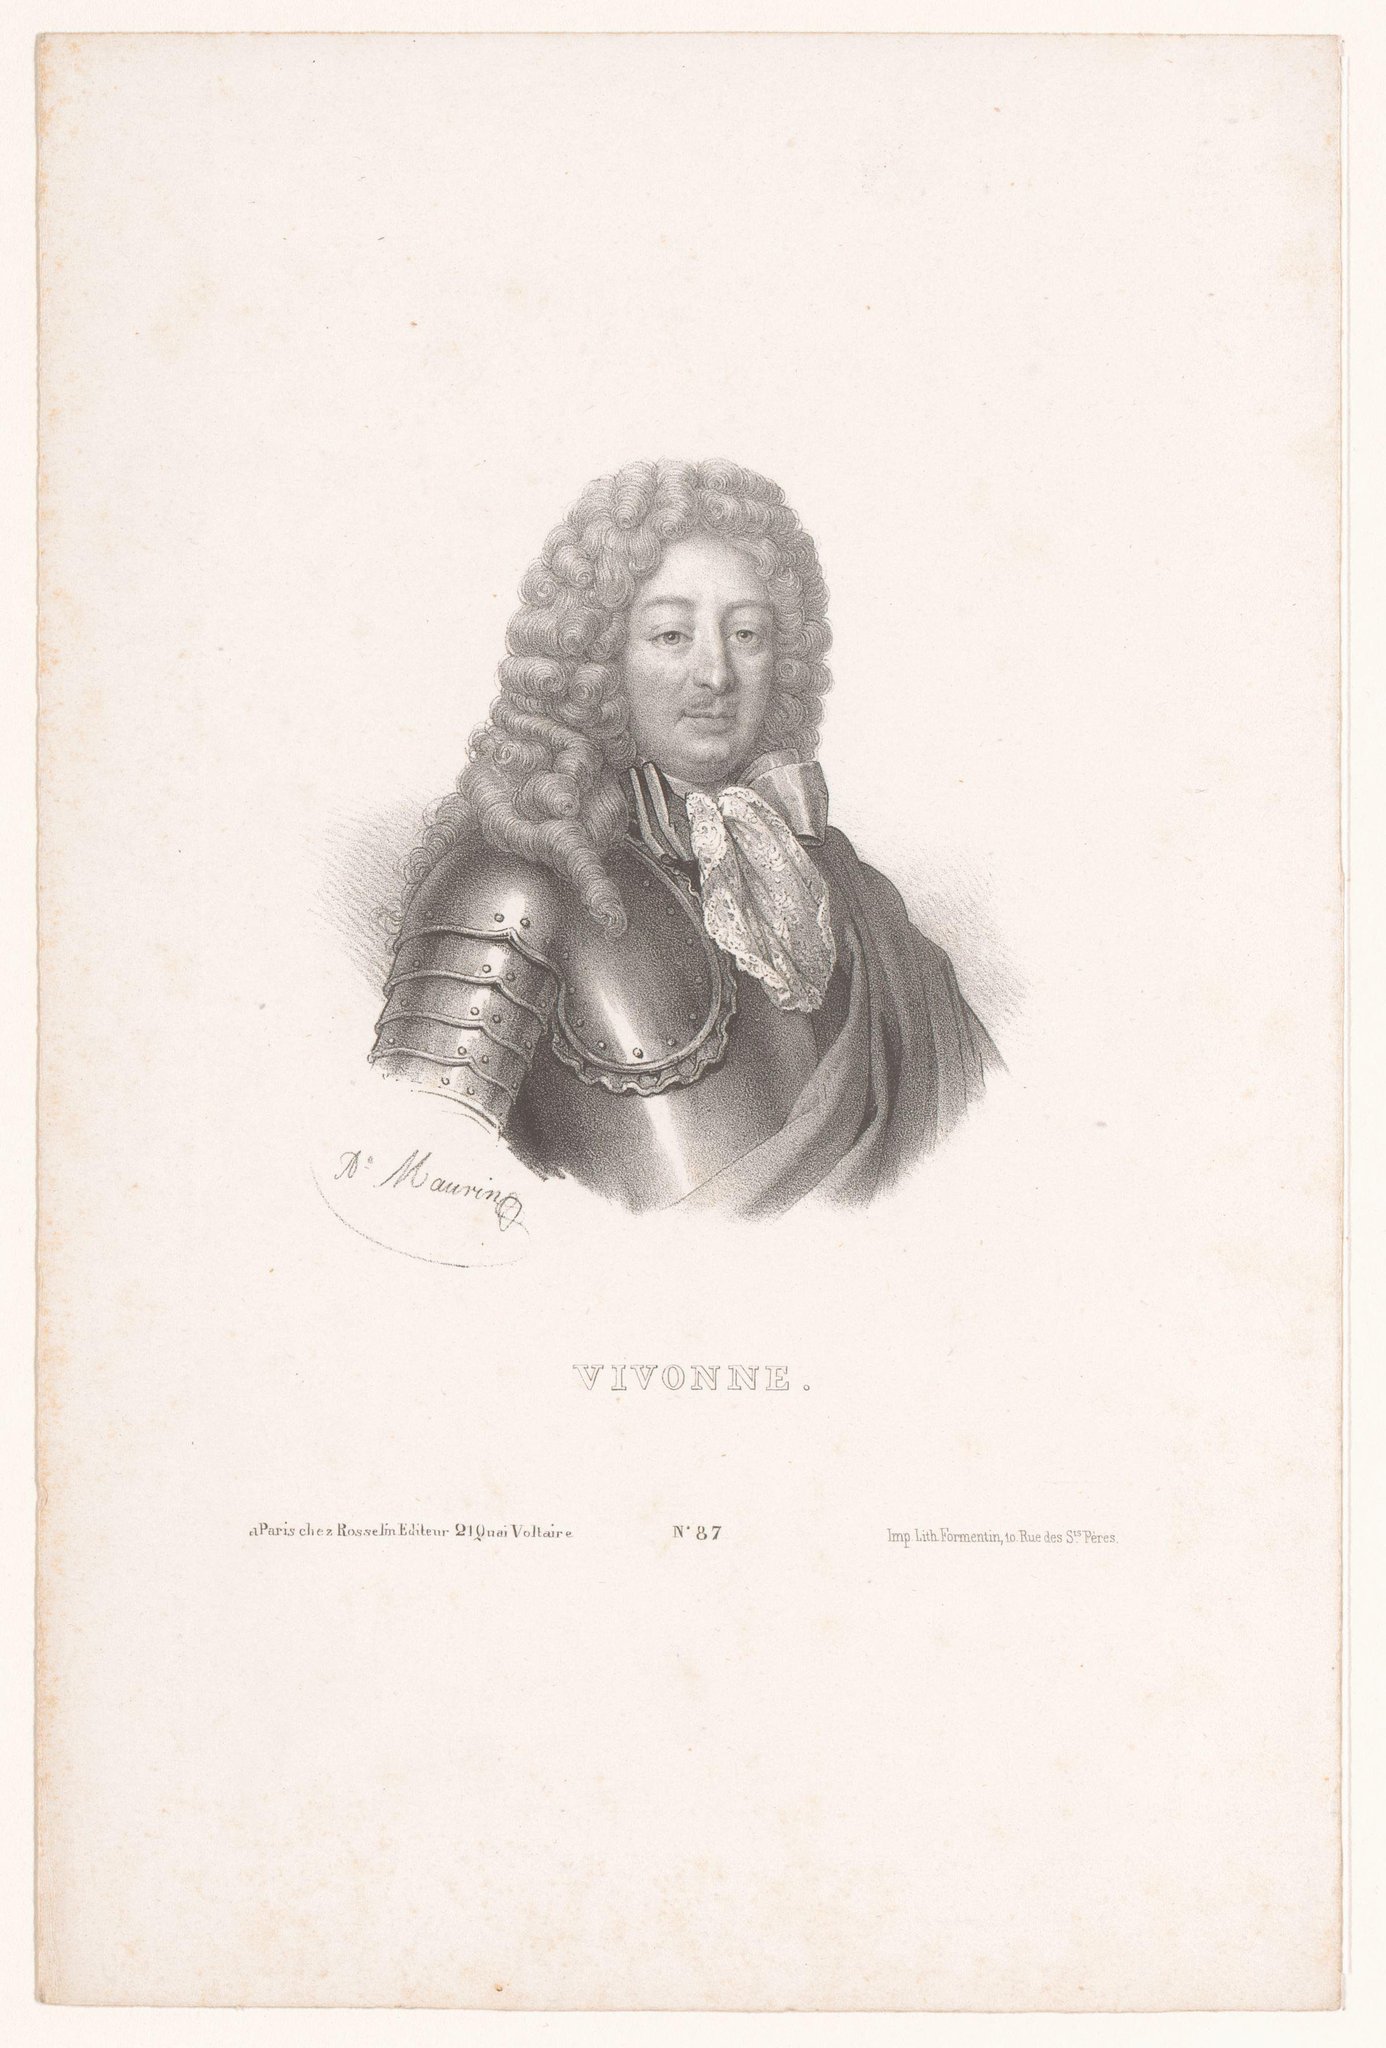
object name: print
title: Vivonne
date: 1830-1856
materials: paper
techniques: lithograph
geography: paris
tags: louis victor rochechouart de mortemart, historical persons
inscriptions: collector's mark: Lugt 2228